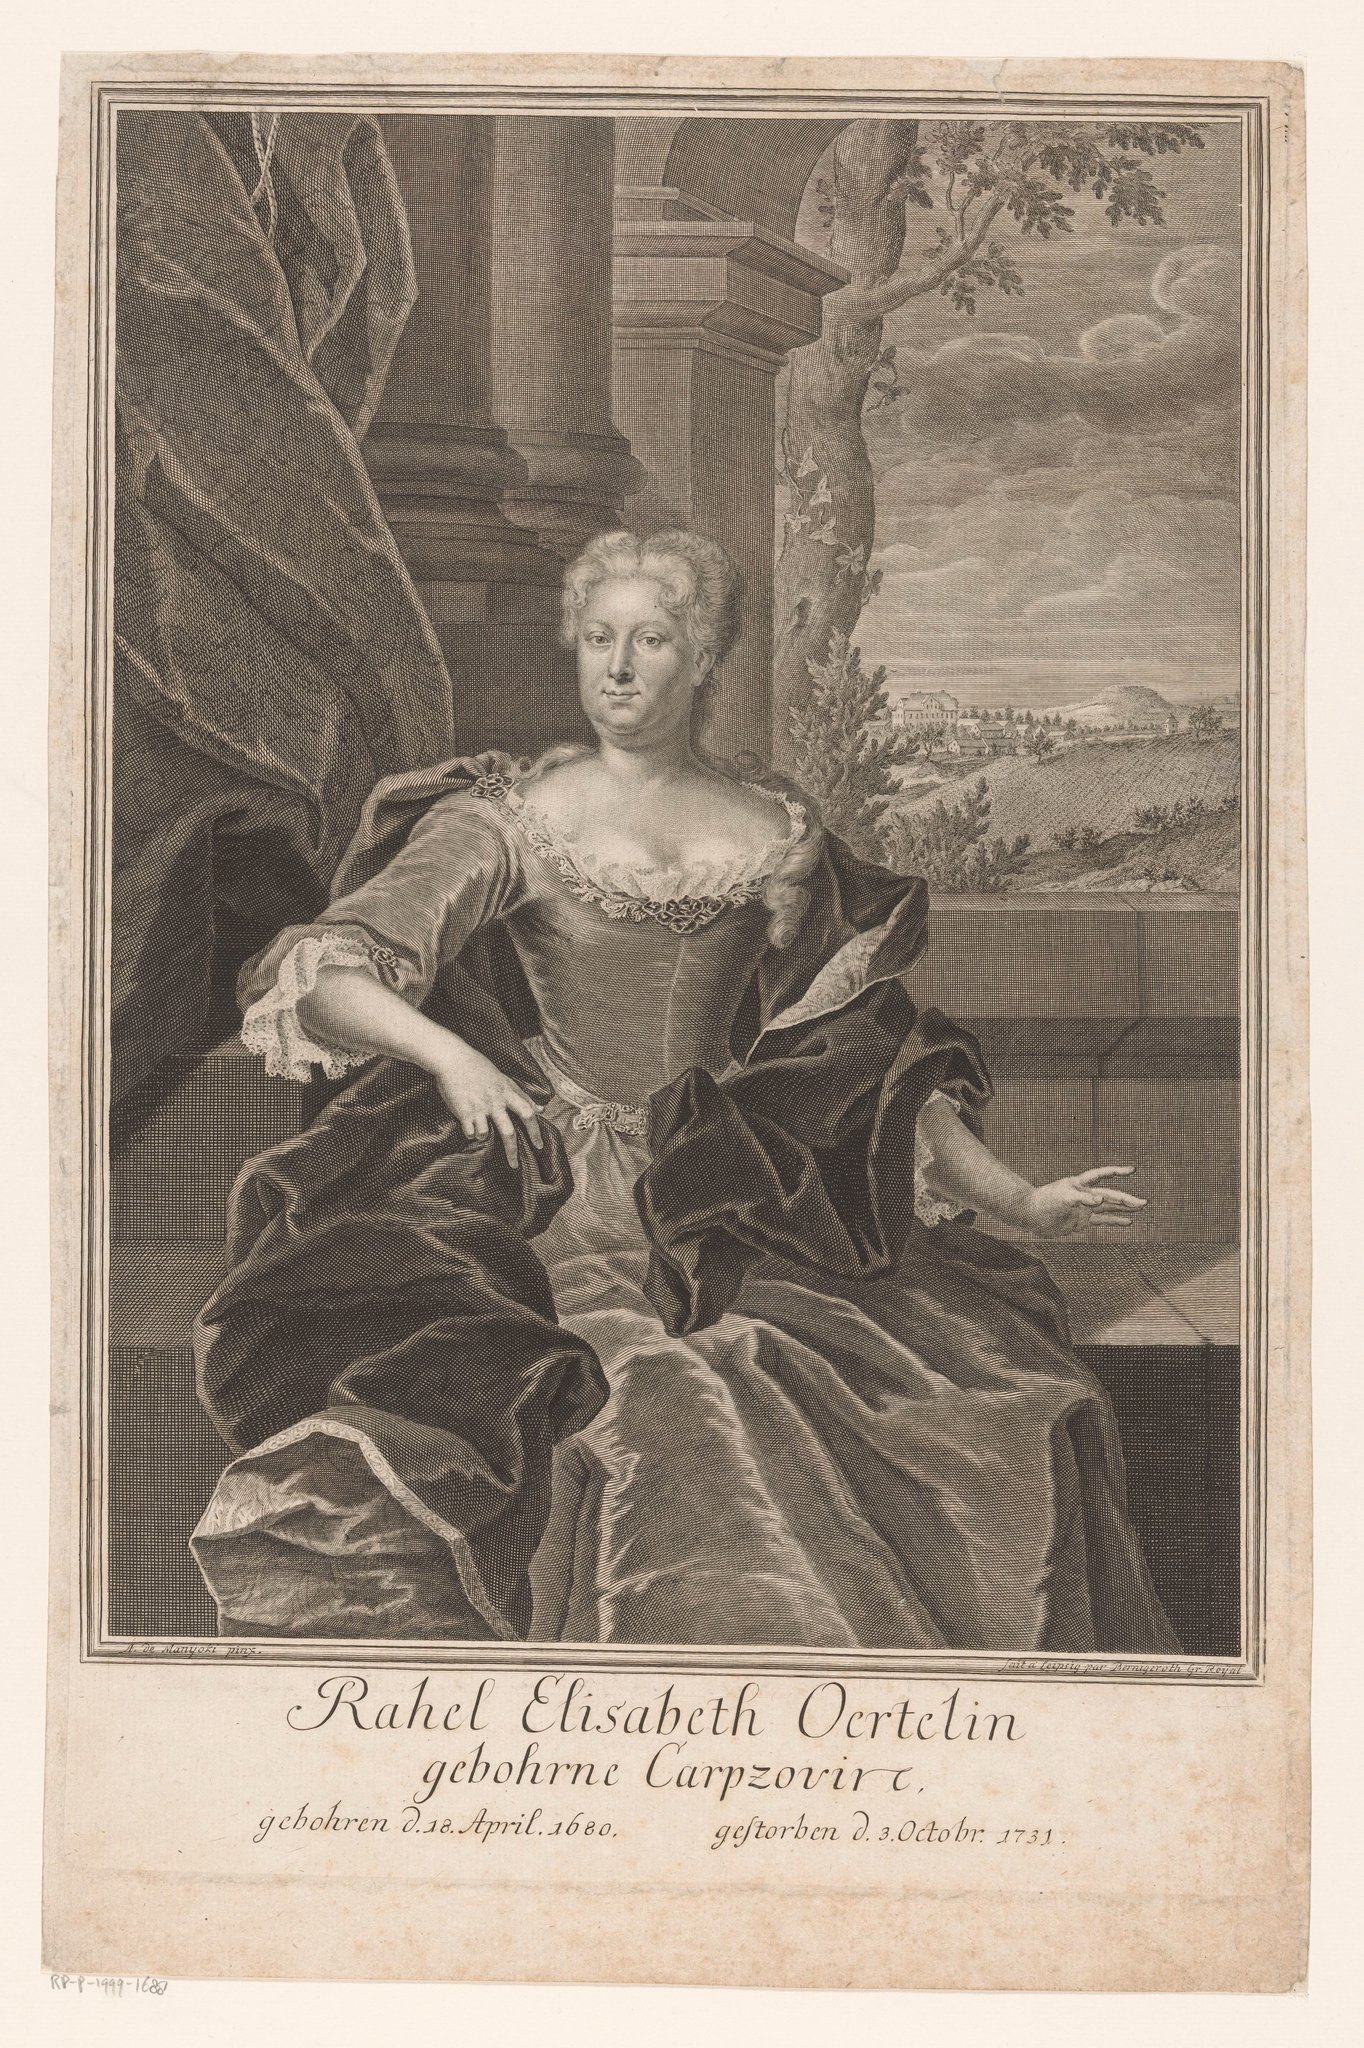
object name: print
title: Portret van Rahel Elisabeth Oertel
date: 1731-1733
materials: paper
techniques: engraving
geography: leipzig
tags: prospect of village, silhouette of village, historical persons - bb - woman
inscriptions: collector's mark: Lugt 2760, collector's mark: Lugt 2228